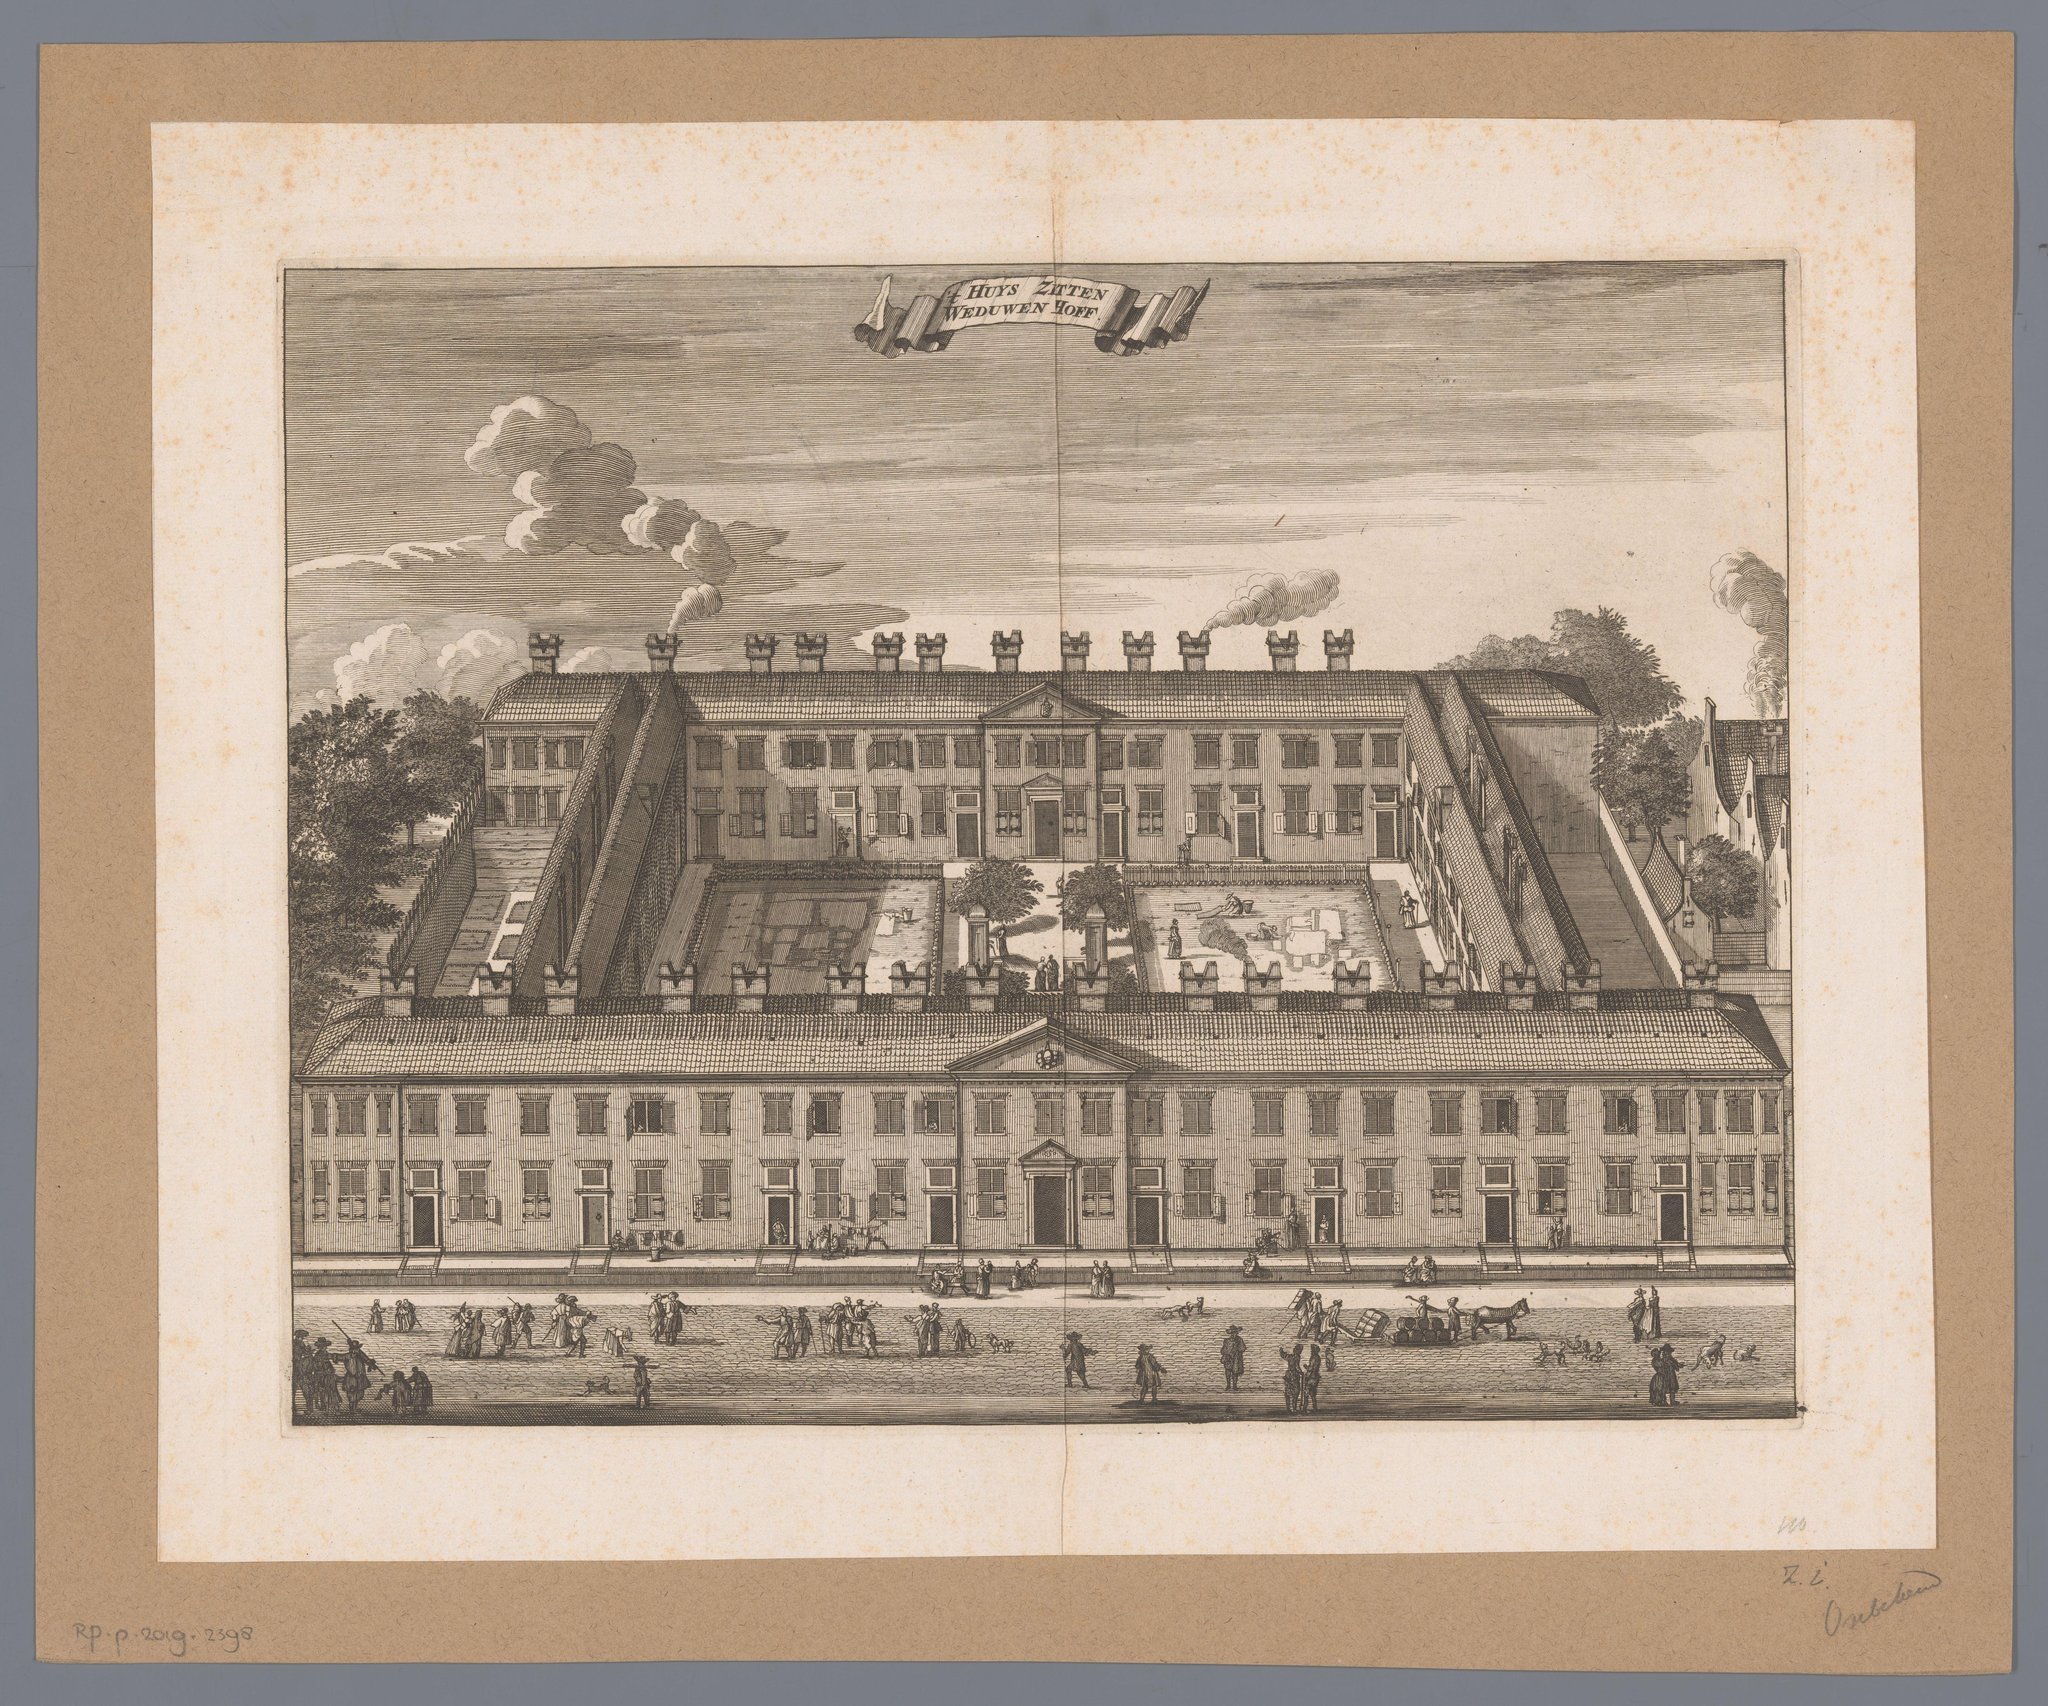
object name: book illustration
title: Gezicht op het Kartuizerhof in Amsterdam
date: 1693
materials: paper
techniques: engraving, etching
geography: amsterdam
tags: old-people's home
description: Prent uit: Commelin, Caspar. Beschryvinge van Amsterdam (...). 2 dln. Amsterdam: Weduwe Dircksz. Oossaan, 1693, dl. 2, p. 580-581.